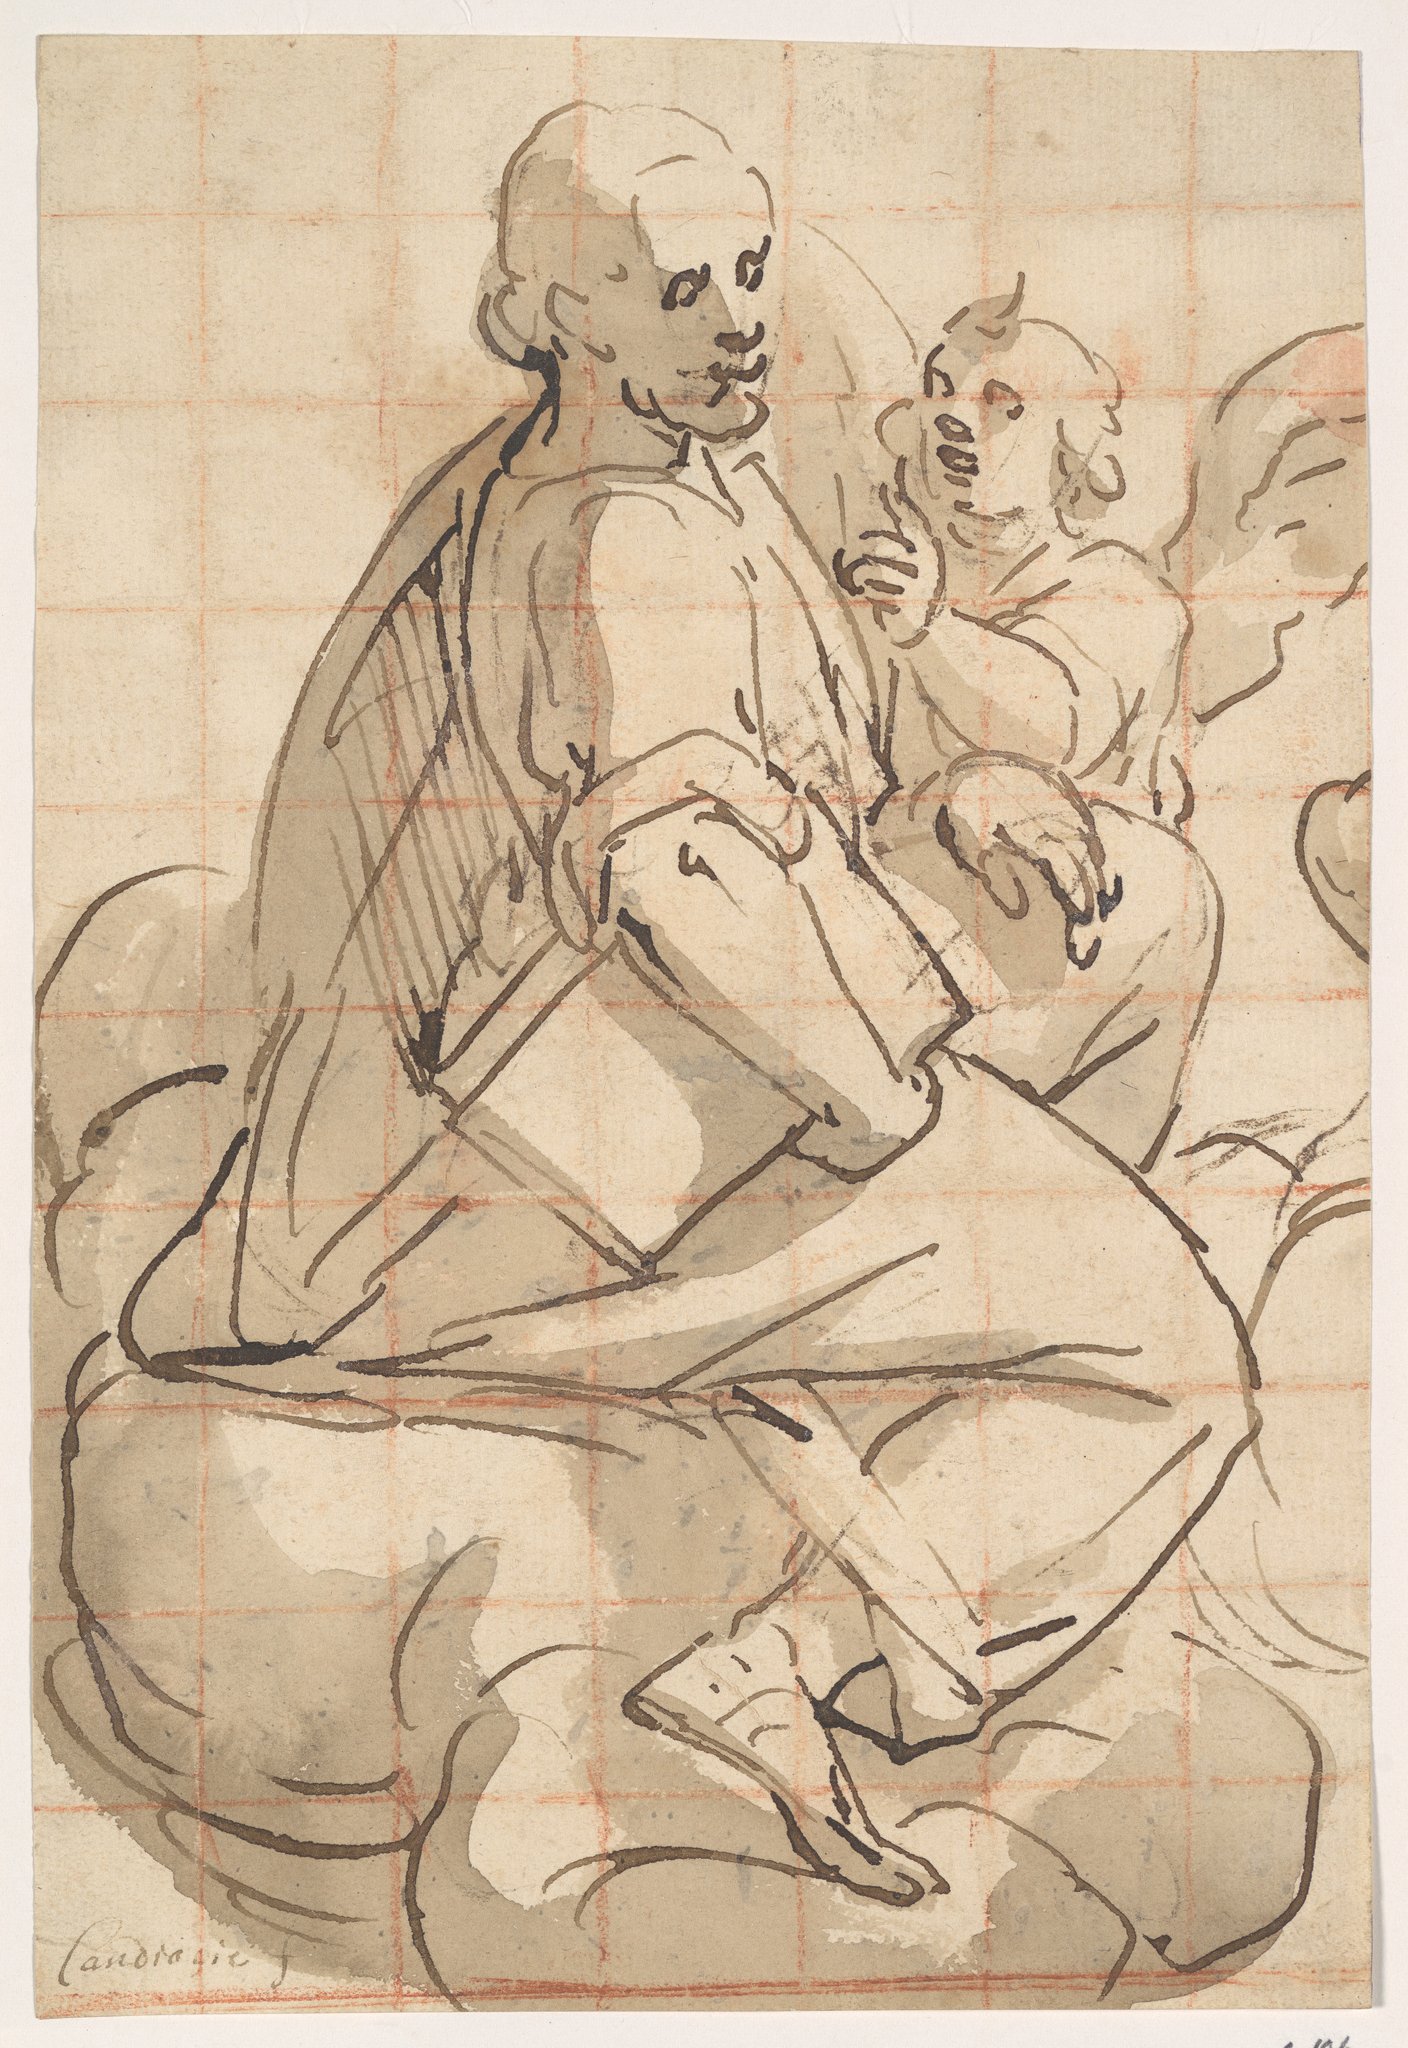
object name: drawing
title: Saint Matthew and the Angel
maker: luca cambiaso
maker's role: artist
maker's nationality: italian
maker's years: 1527-1585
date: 1583-1585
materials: chalk, ink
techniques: pen, drawing, wash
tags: angels,saint matthew